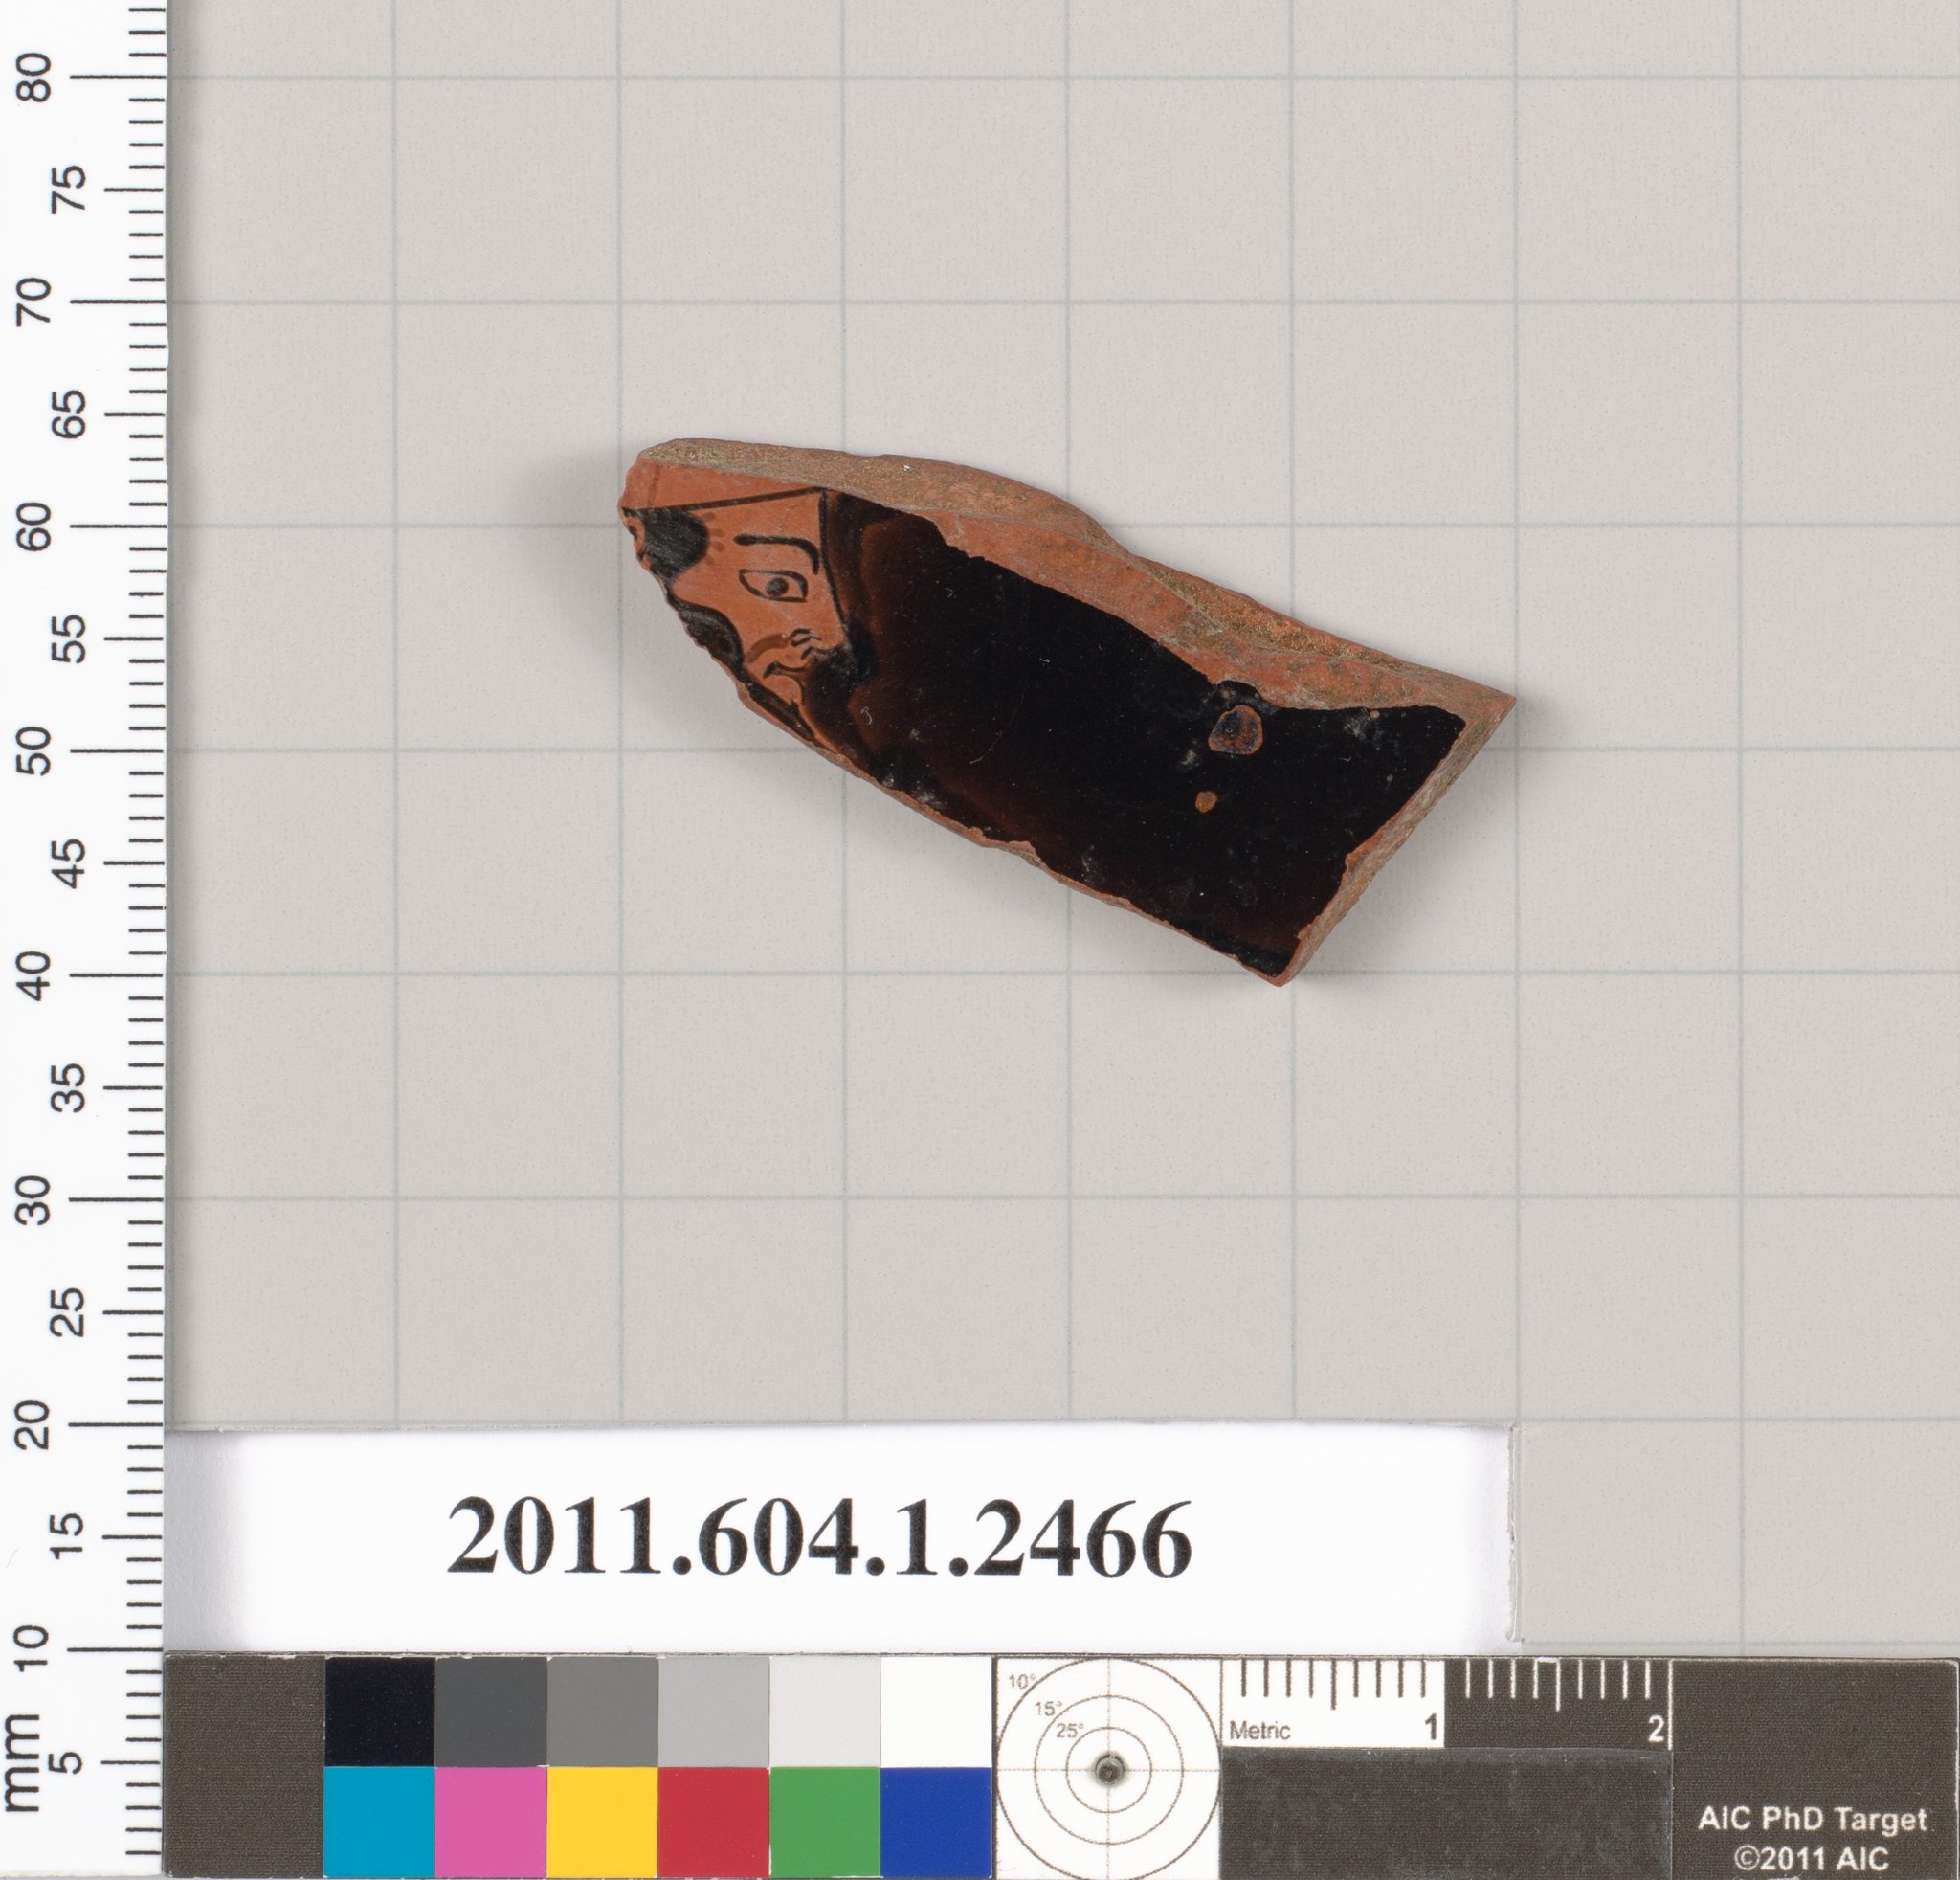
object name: kylix fragment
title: Terracotta fragment of a kylix (drinking cup)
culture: greek, attic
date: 500-490 BCE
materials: terracotta